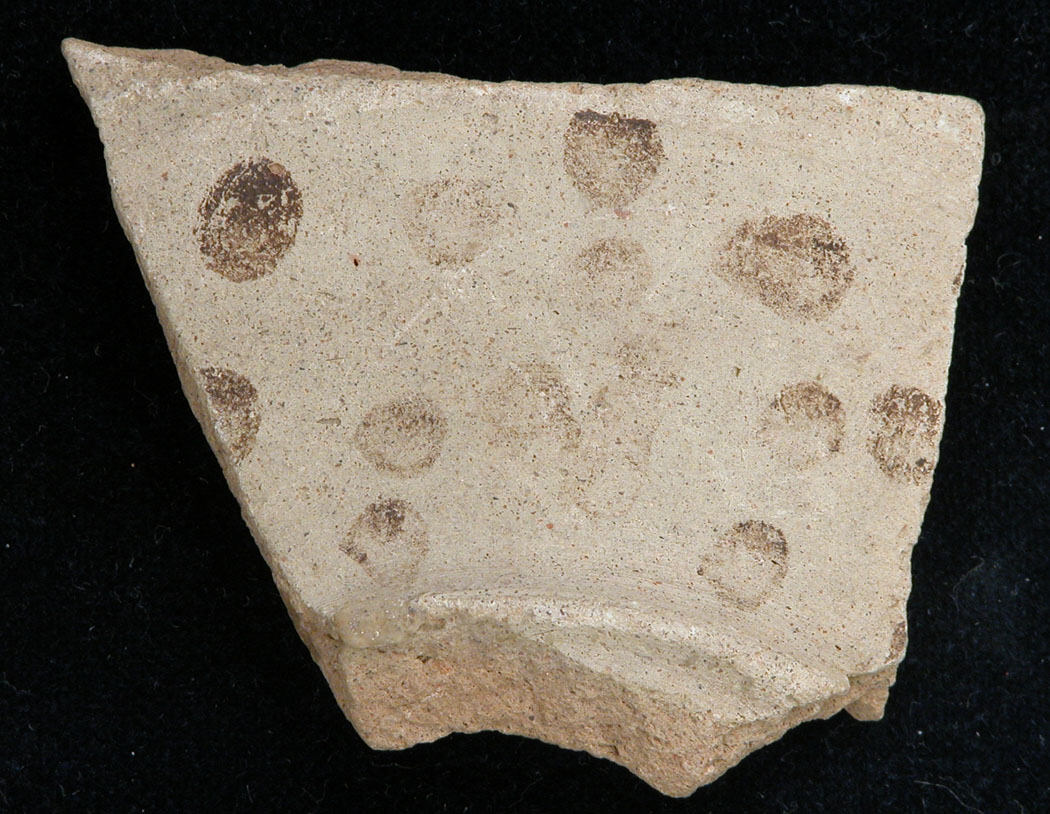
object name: fragment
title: Ceramic Fragment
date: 701-900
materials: earthenware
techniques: glazing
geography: iraq